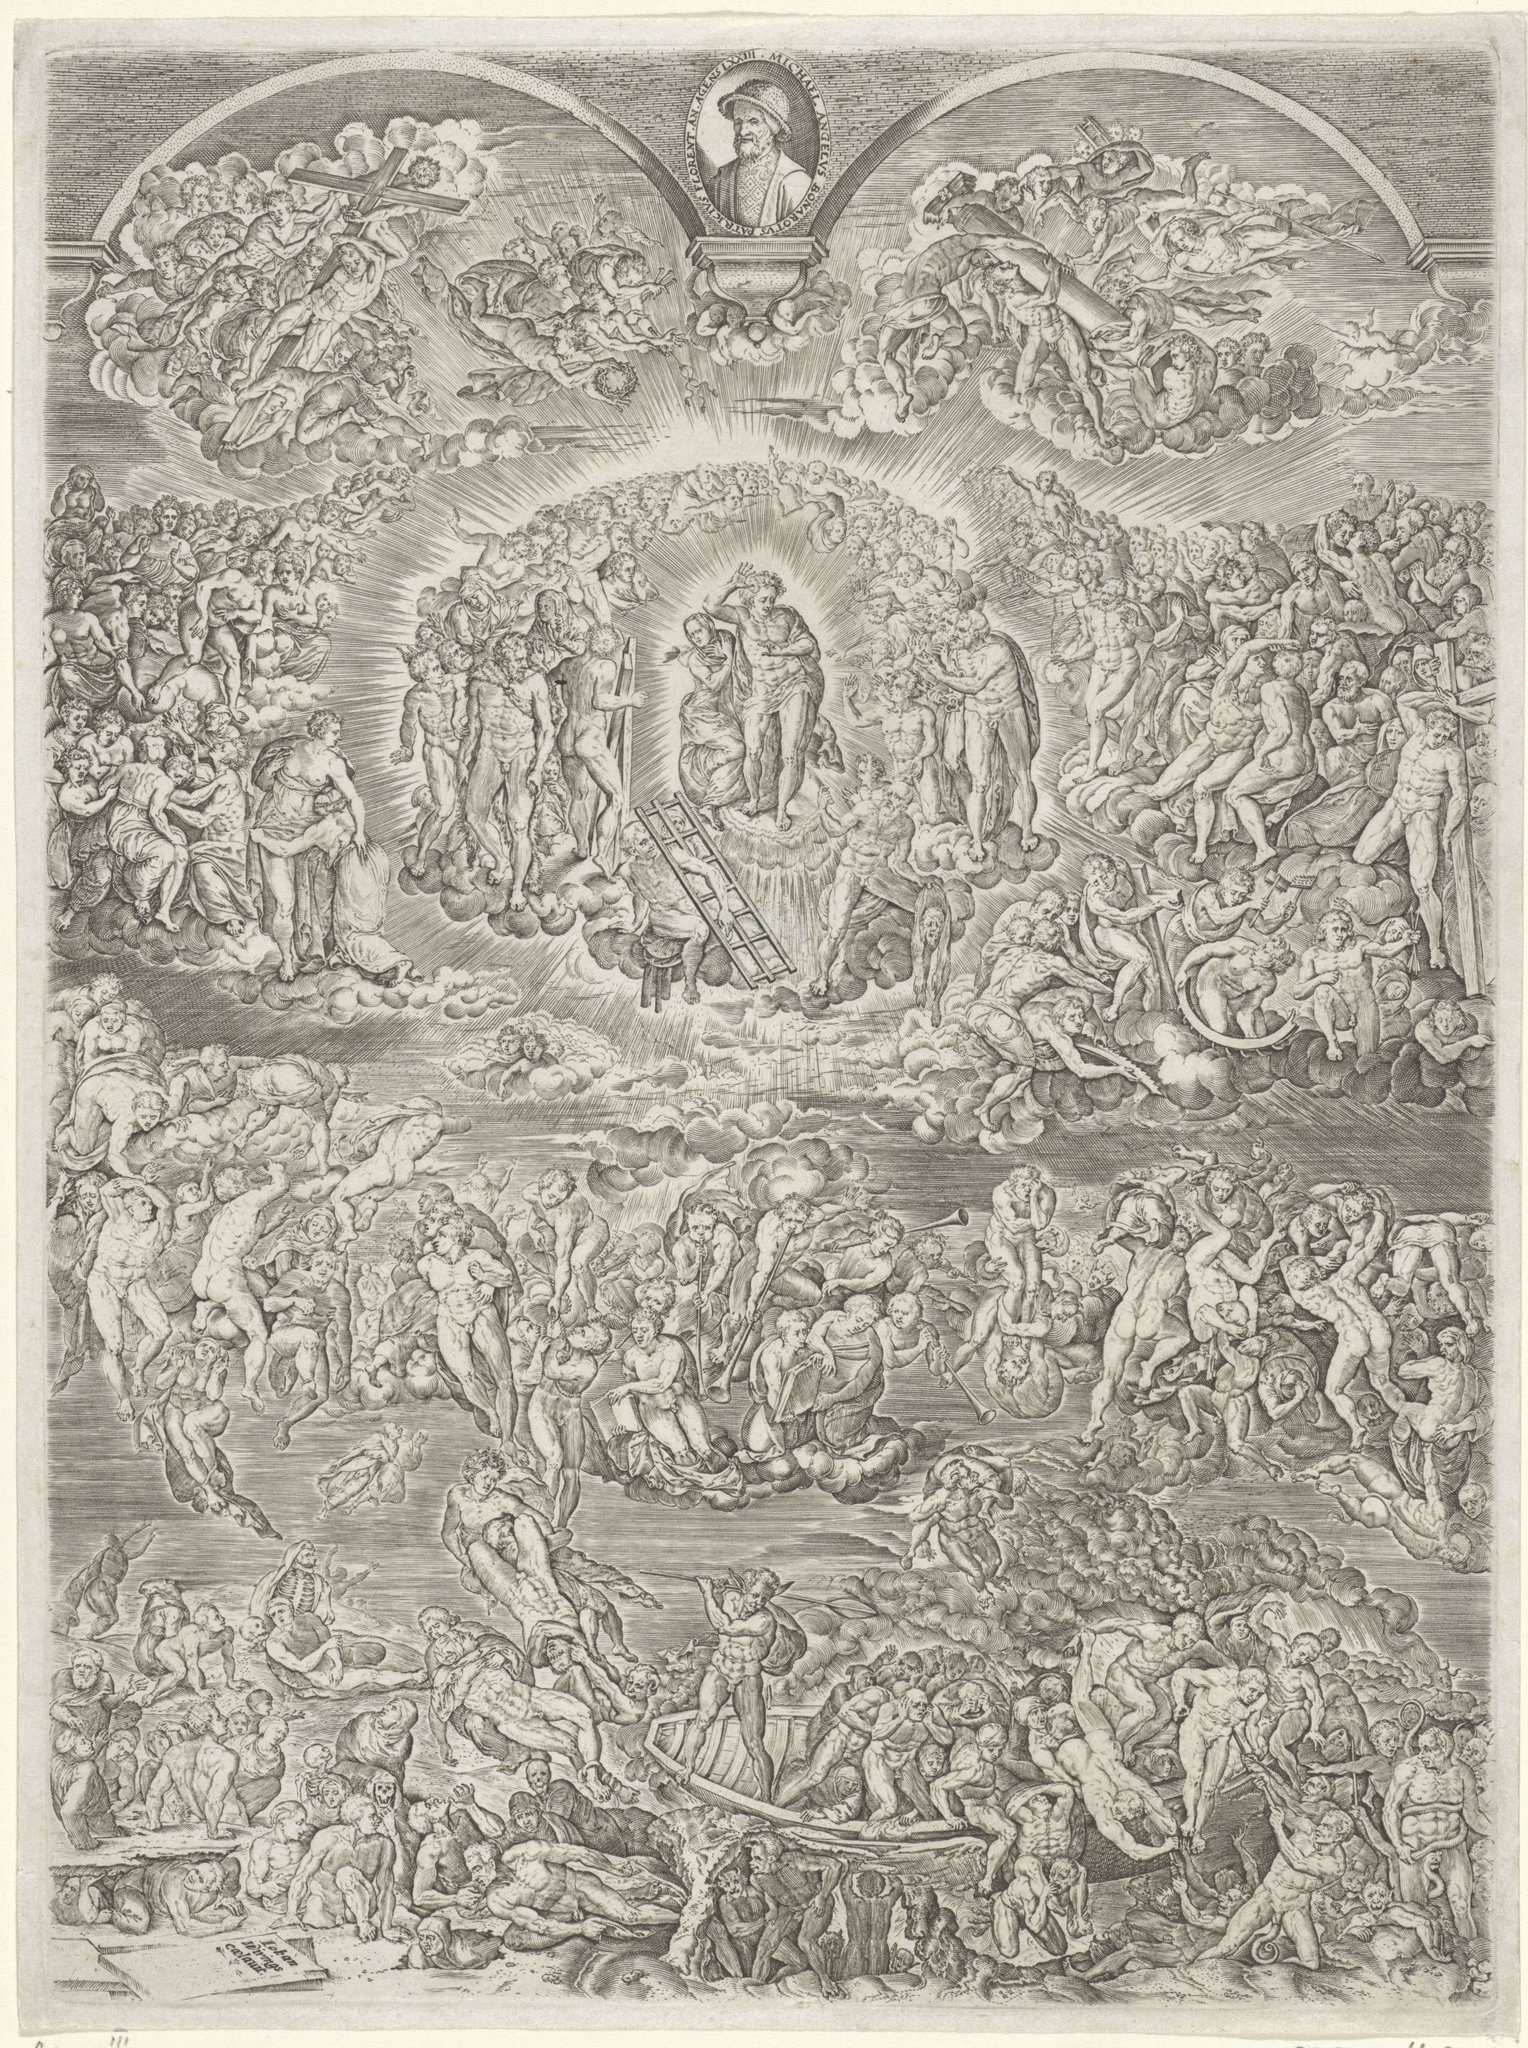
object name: print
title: Laatste Oordeel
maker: johannes wierix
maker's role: draughtsman, print maker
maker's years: 1549-1618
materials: paper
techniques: engraving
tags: rome, painter, draughtsman, sculptor, michelangelo, comprehensive representation of last judgement: christ (with sword and lily), often surrounded by elders and sometimes accompanied by mary and john the baptist, appears in the sky with trumpeting angels (and sometimes angels holding the instruments of the passion); after the resurrection of the dead the blessed are led to heaven by angels, and the damned are dragged into hell by devils, charon, the ferryman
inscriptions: collector's mark: Lugt 2228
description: Christus treedt op als rechter. Hij staat op een wolk naast Maria. Met zijn geheven arm maakt hij een dreigend gebaar. Hij wordt omringd door groepen met cherubijnen, heiligen en apostelen. Geheel onderaan de verdoemden die door duivels meegenomen worden naar de hel en daar worden gefolterd. Charon zet de doden over met zijn boot. Bovenaan een portret van de schilder Michelangelo, op 73-jarige leeftijd. De prent is gemaakt naar diens fresco in de Sixtijnse kapel te Rome.